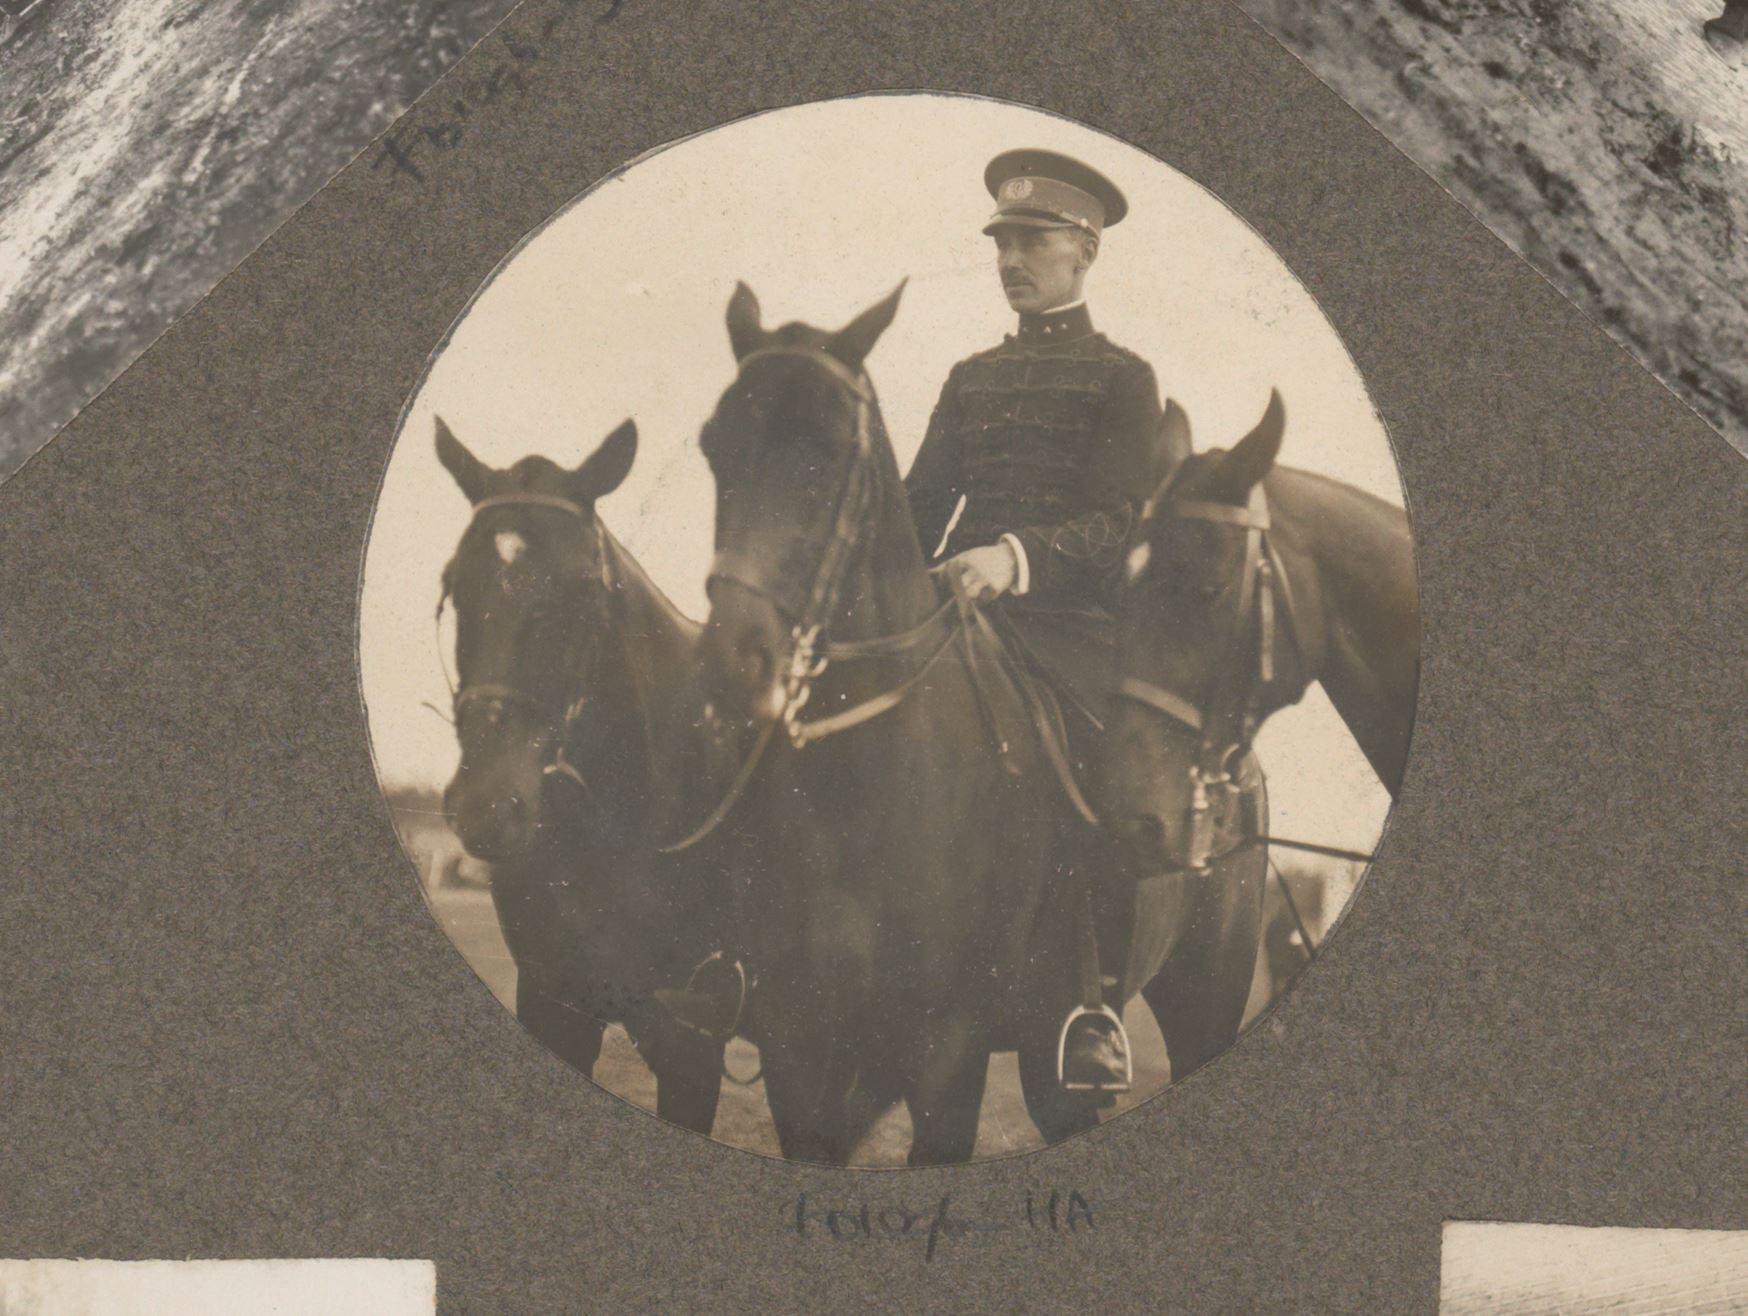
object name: photograph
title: Ruitertafereel op Koninklijke Houtvesterij Het Loo: geüniformeerde ruiter leidt twee andere paarden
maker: Anonymous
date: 1900-1925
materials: photographic support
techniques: gelatin silver print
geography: het loo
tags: riding a horse, ass, or mule; rider, horseman, hunting, chase, hunting-ground, horse, (military) uniforms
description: Onderdeel van Fotoalbum van de heer Brams, opperhoutvester van koningin Wilhelmina op Koninklijke Houtvesterij Het Loo.